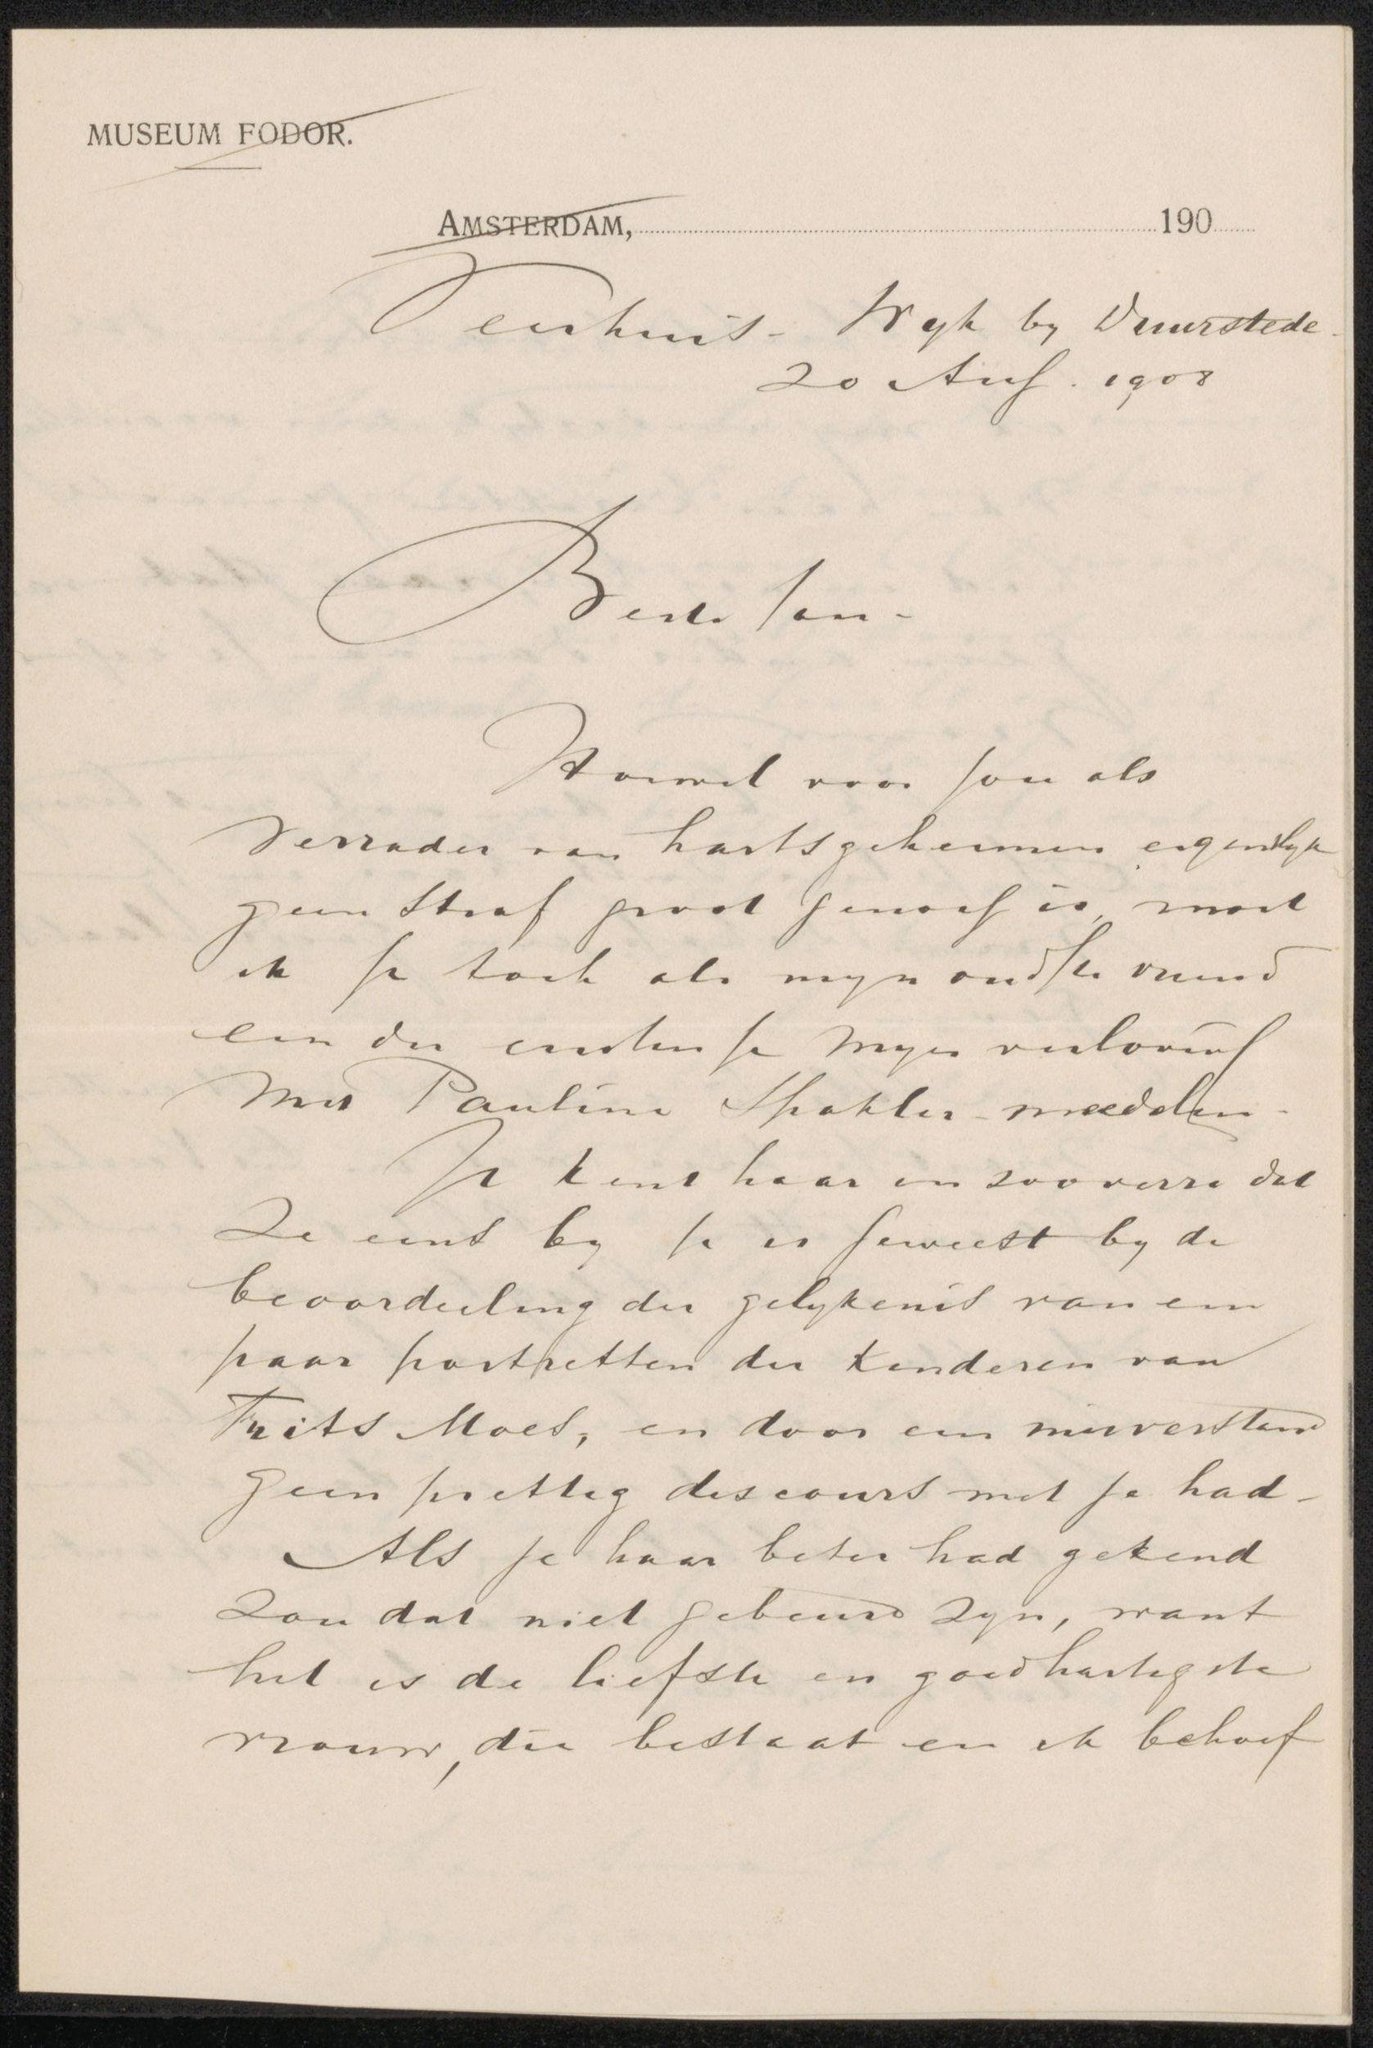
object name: letter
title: Brief aan Jan Veth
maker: cornelis gerardus t hooft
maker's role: draughtsman, painter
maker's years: 1866-1936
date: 1908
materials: ink, paper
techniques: pen, printing, writing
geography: wijk bij duurstede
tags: pauline ernestine 't hooft-spakler, jan veth, historical persons (portraits and scenes from the life), berlin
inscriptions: collector's mark: ‘RPK’